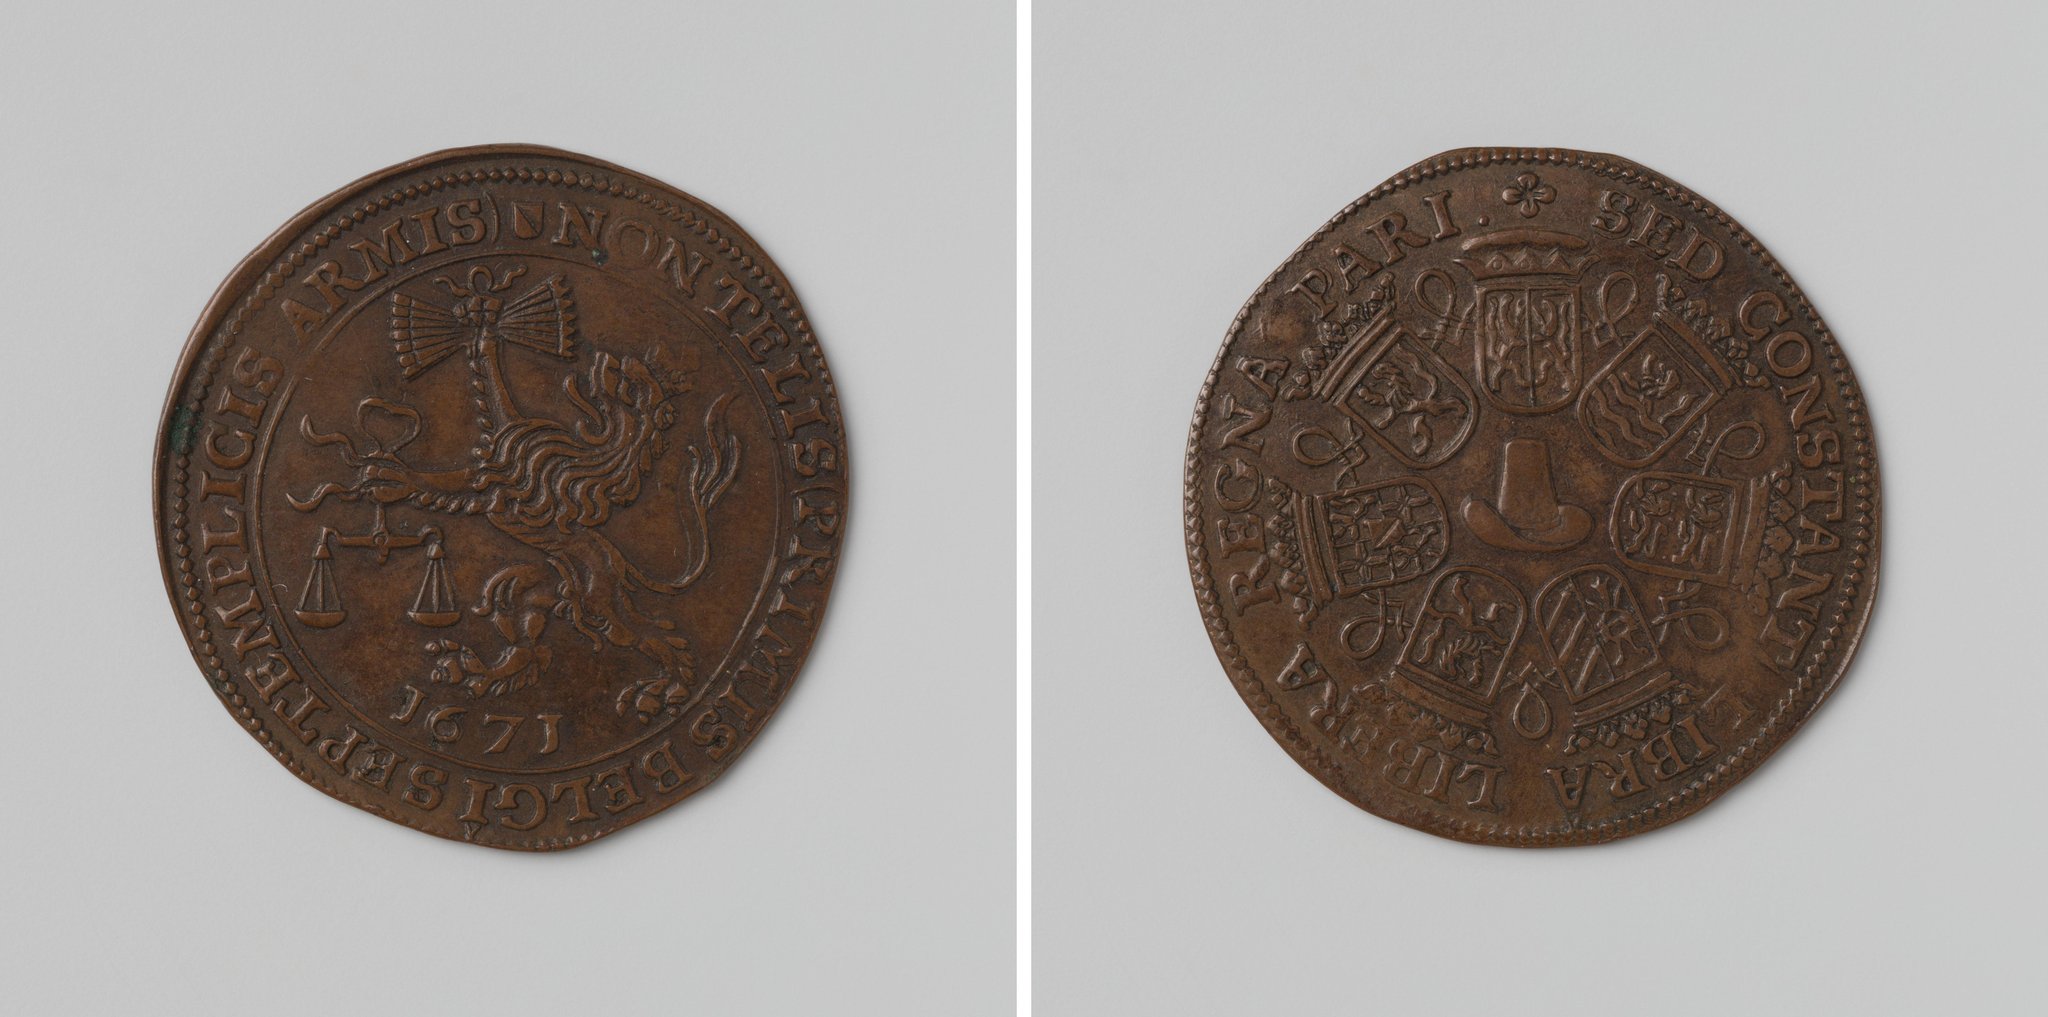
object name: jeton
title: Vredelievende gezindheid van de Republiek der Verenigde Nederlanden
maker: Anonymous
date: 1671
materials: copper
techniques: striking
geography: utrecht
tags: netherlands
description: Koperen penning. Voorzijde: gekroonde leeuw met bundel van zeven pijlen in rechter- en weegschaal in linkerklauw boven jaartal binnen omschrift. Keerzijde: vrijheidshoed, omgeven door rand van zeven met lint samengebonden gekroonde wapenschilden binnen omschrift